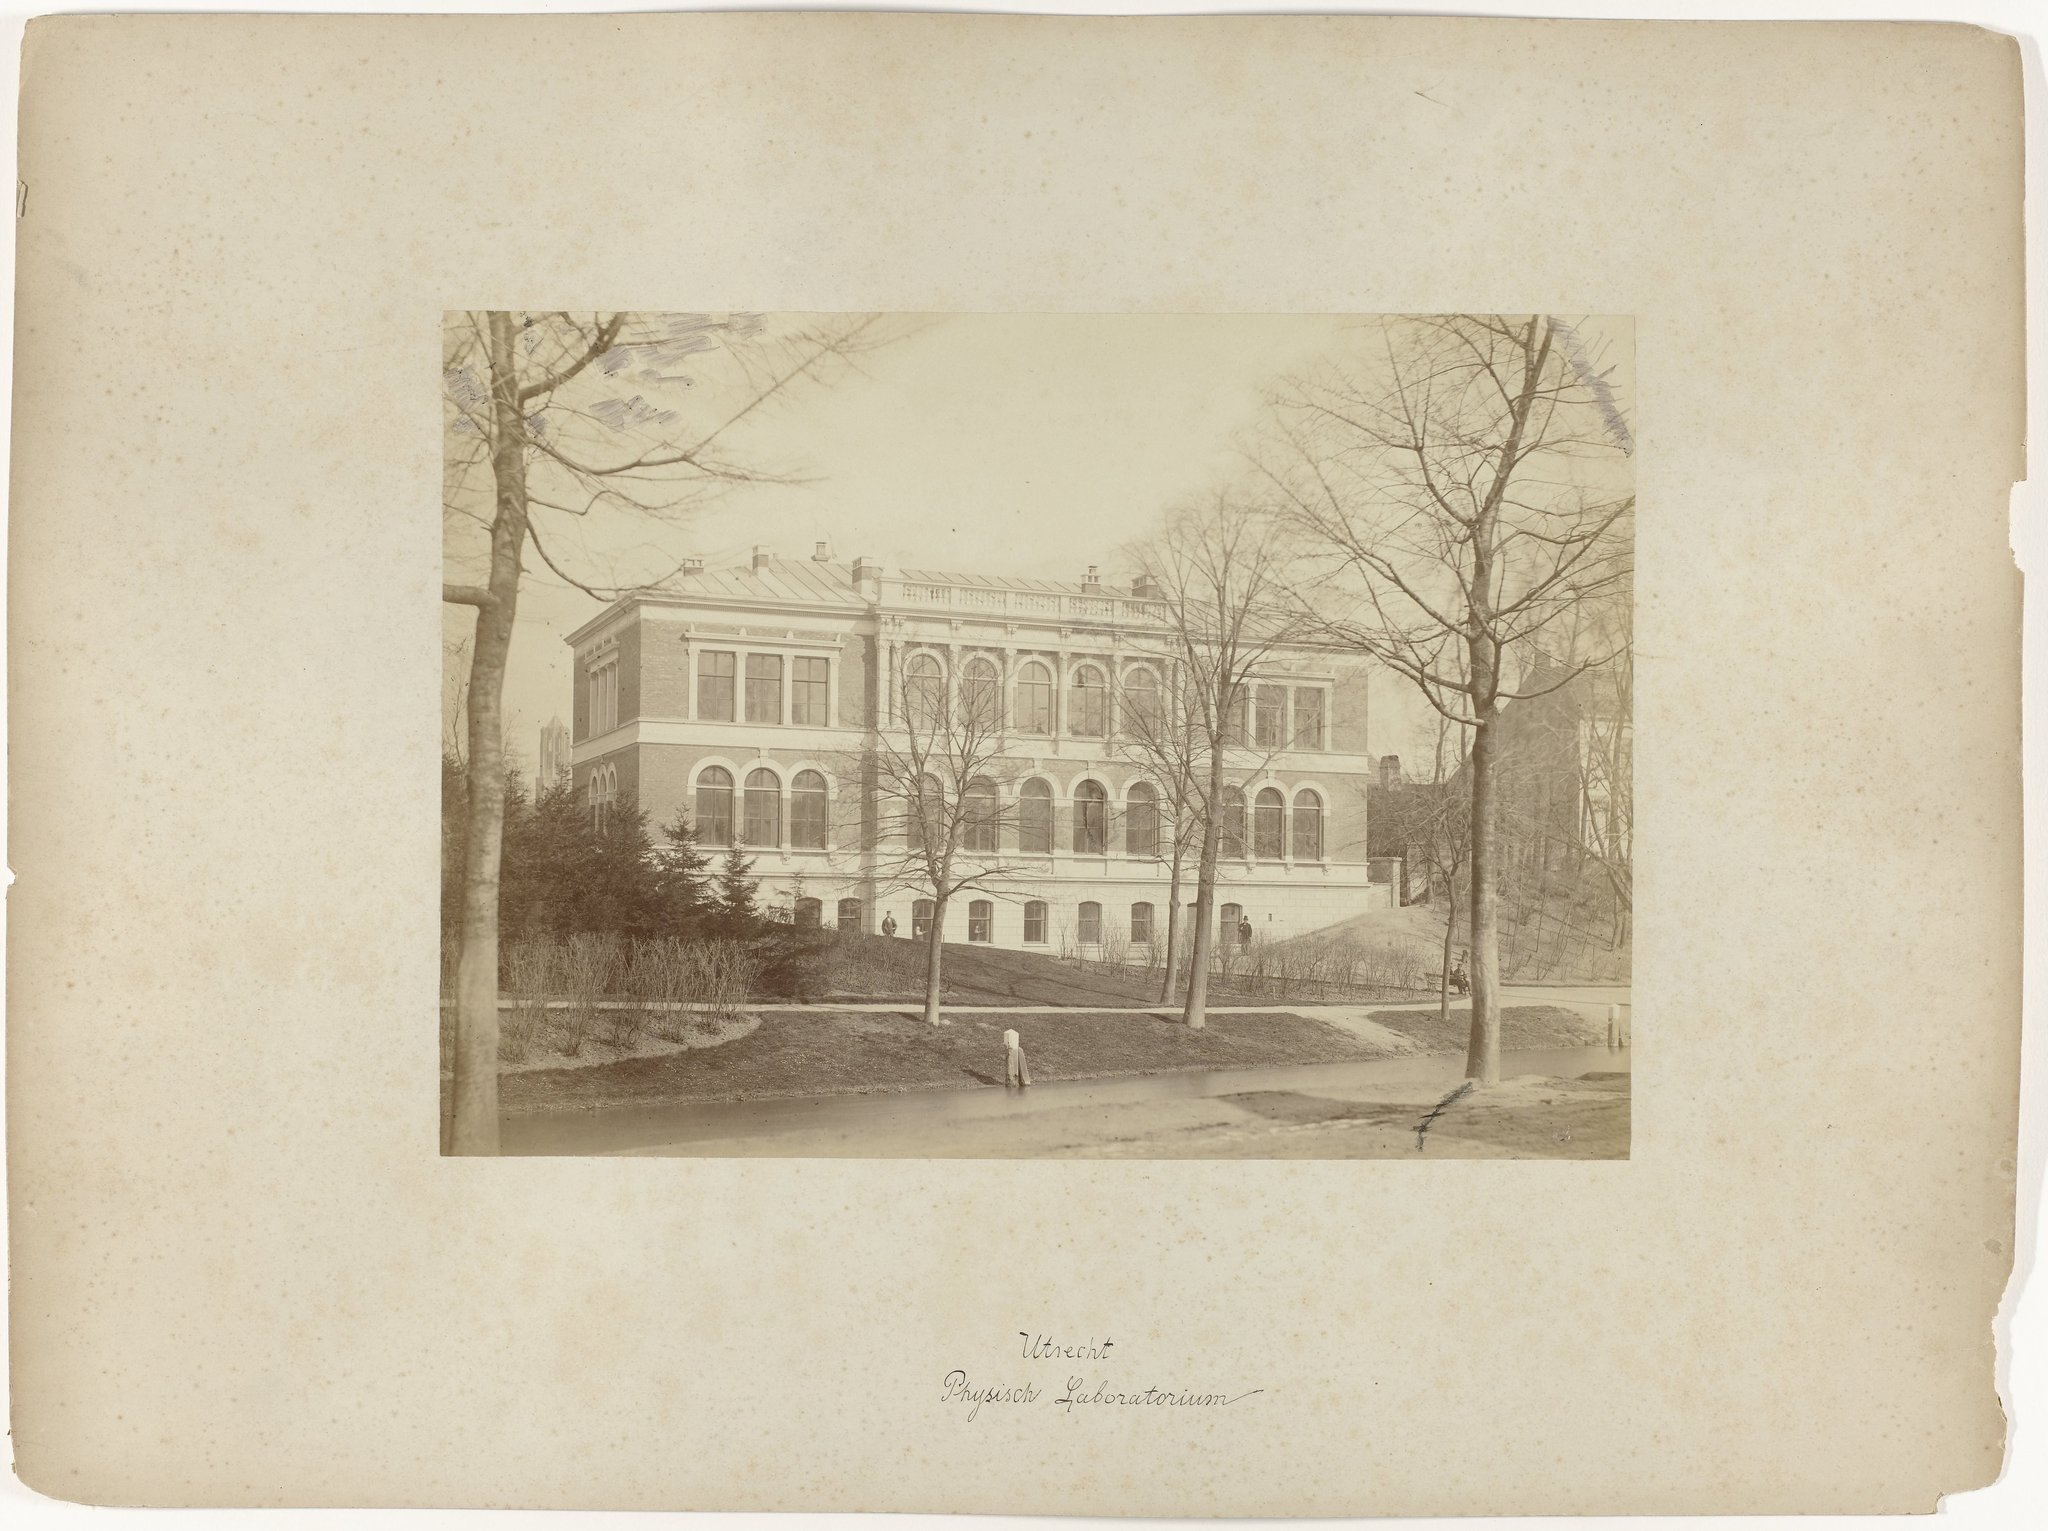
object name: photograph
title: Gezicht op het Physisch Laboratorium in de Bijlhouwerstraat in Utrecht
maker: eduard françois georges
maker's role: sculptor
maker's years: 1817-1895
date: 1877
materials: cardboard, photographic support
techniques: albumen print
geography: utrecht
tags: laboratory, university, utrecht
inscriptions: inscription